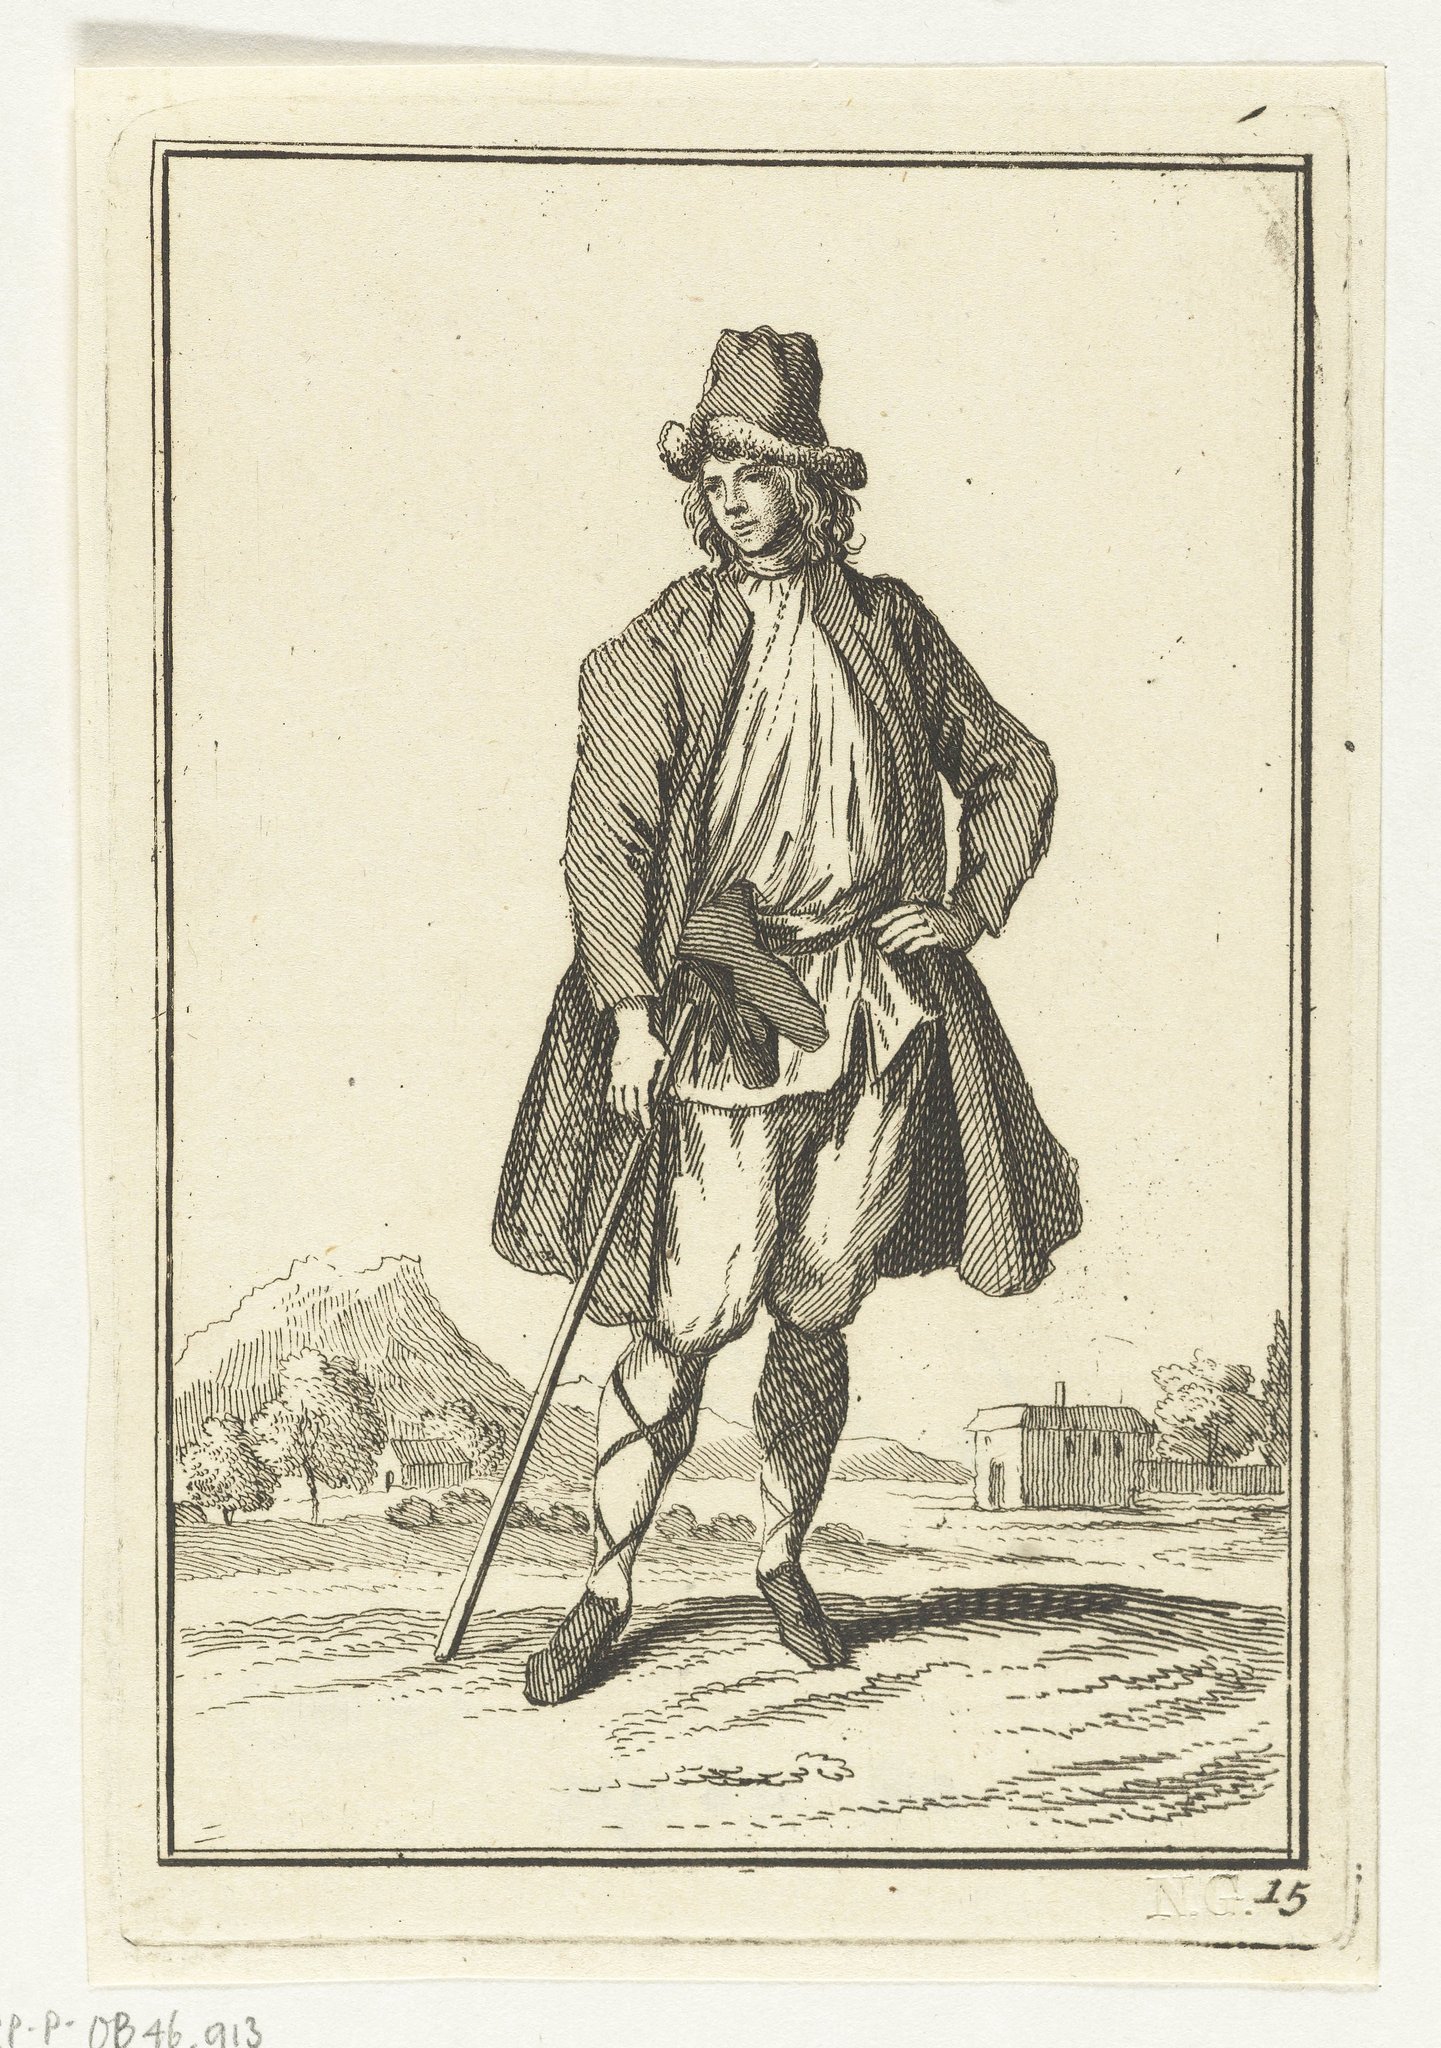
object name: costume print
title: Man met hoed en stok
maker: adolf van der laan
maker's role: draughtsman, print maker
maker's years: 1689-1742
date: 1710-1755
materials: paper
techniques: etching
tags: europeans (with name) (+ costume), clothes, costume (+ men's clothes)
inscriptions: collector's mark: Lugt 1967, collector's mark: Lugt 2228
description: Man in een landschap, gekleed als Savooiaard. Ten voeten uit, van voren gezien. Gehuld in een halflange overjas en kniebroek, om de kousen beenwindsels. Op het hoofd een hoed met bontrand, in de rechterhand een stok. De prent maakt deel uit van een zestiendelige serie prenten met voorstellingen van Hollandse kostuums.